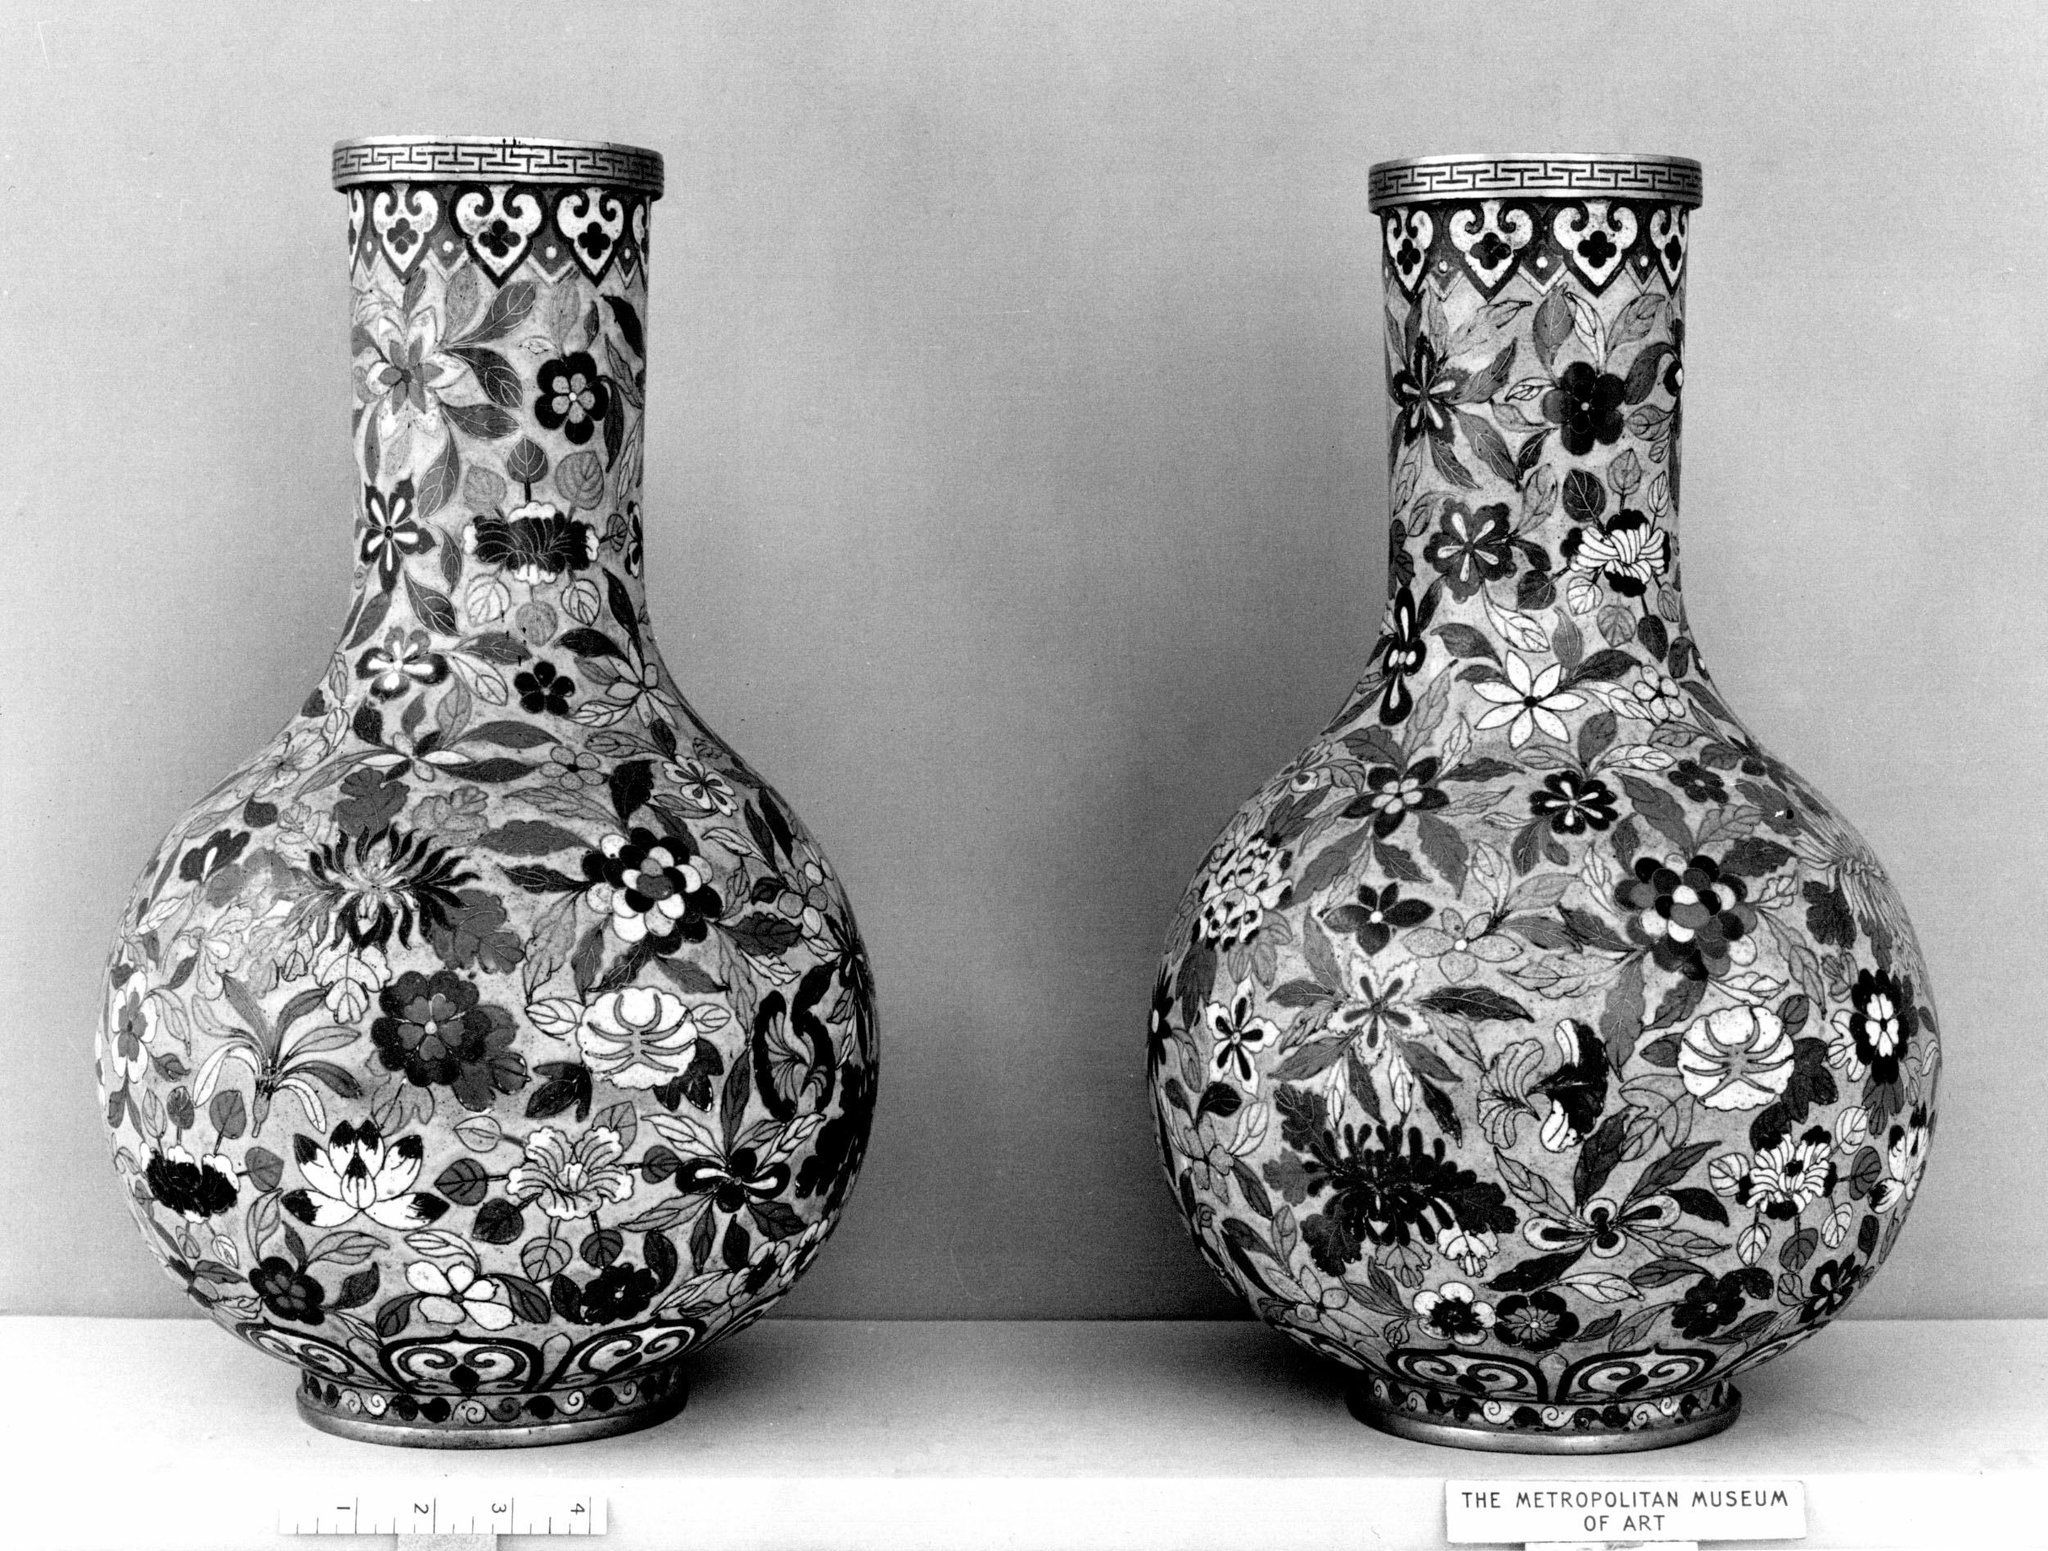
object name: vase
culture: chinese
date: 1801-1900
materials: enamel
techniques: enamel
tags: flowers,leaves